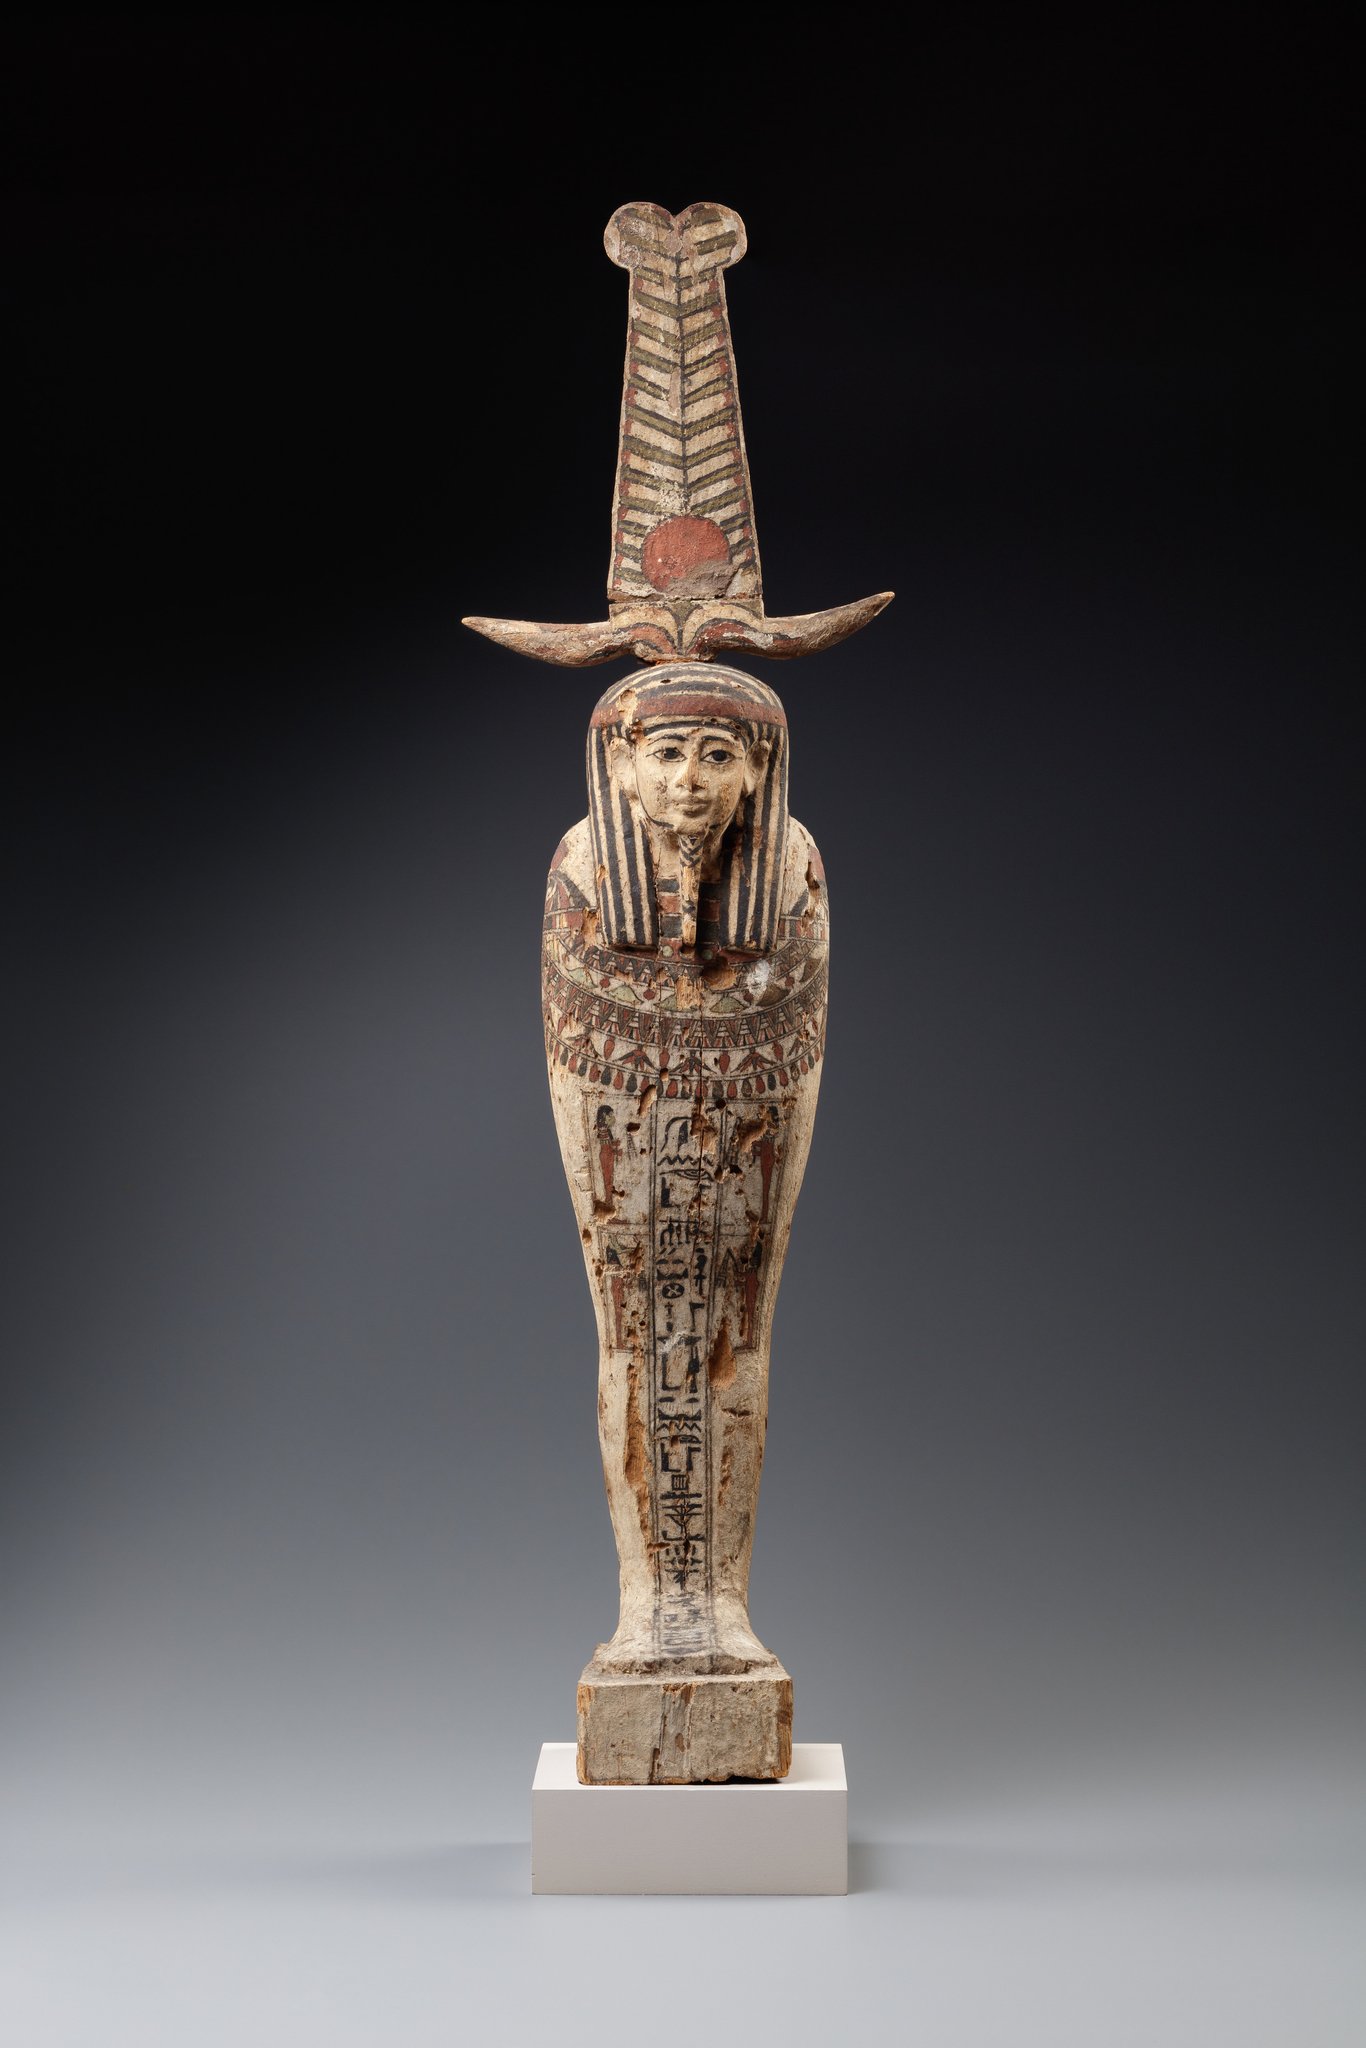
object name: funerary figure, ptah sokar osiris, pestjauwymin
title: Ptah-Sokar-Osiris Figure inscribed for Pestjauwymin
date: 664-332 BCE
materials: paint, paste, wood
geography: egypt